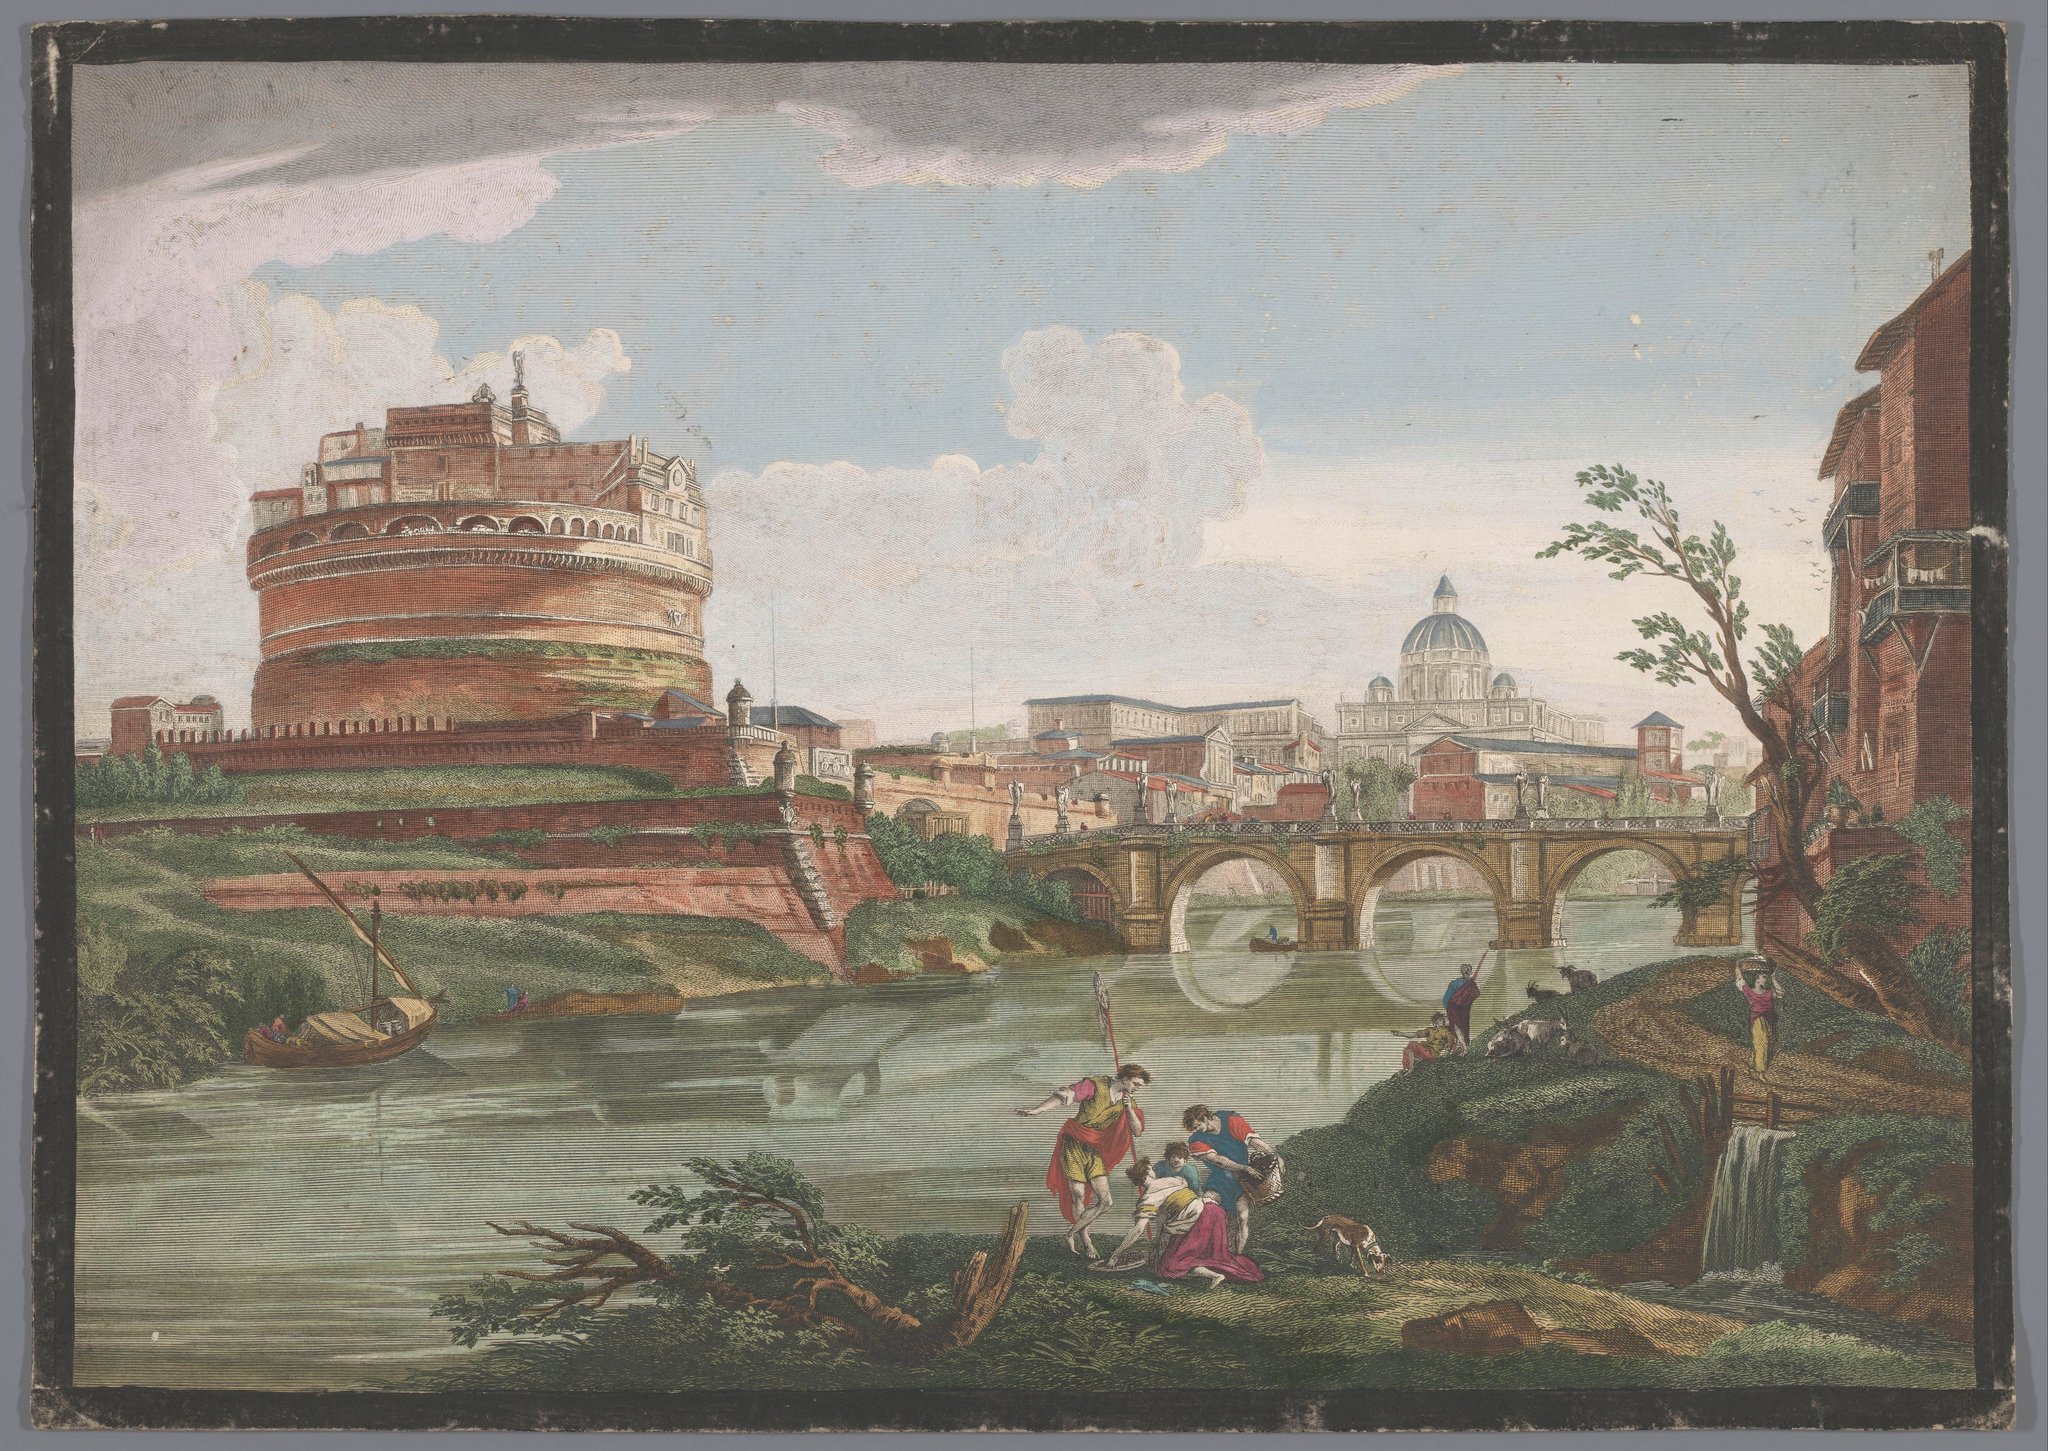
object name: opticaprent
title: Gezicht op de Engelenburcht en de Engelenbrug over de rivier de Tiber te Rome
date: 1759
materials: cardboard, paper, watercolor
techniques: brush, etching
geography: paris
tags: fortress, bridge in city across river, canal, etc. (+ city(-scape) with figures, staffage)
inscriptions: collector's mark: Lugt 2233